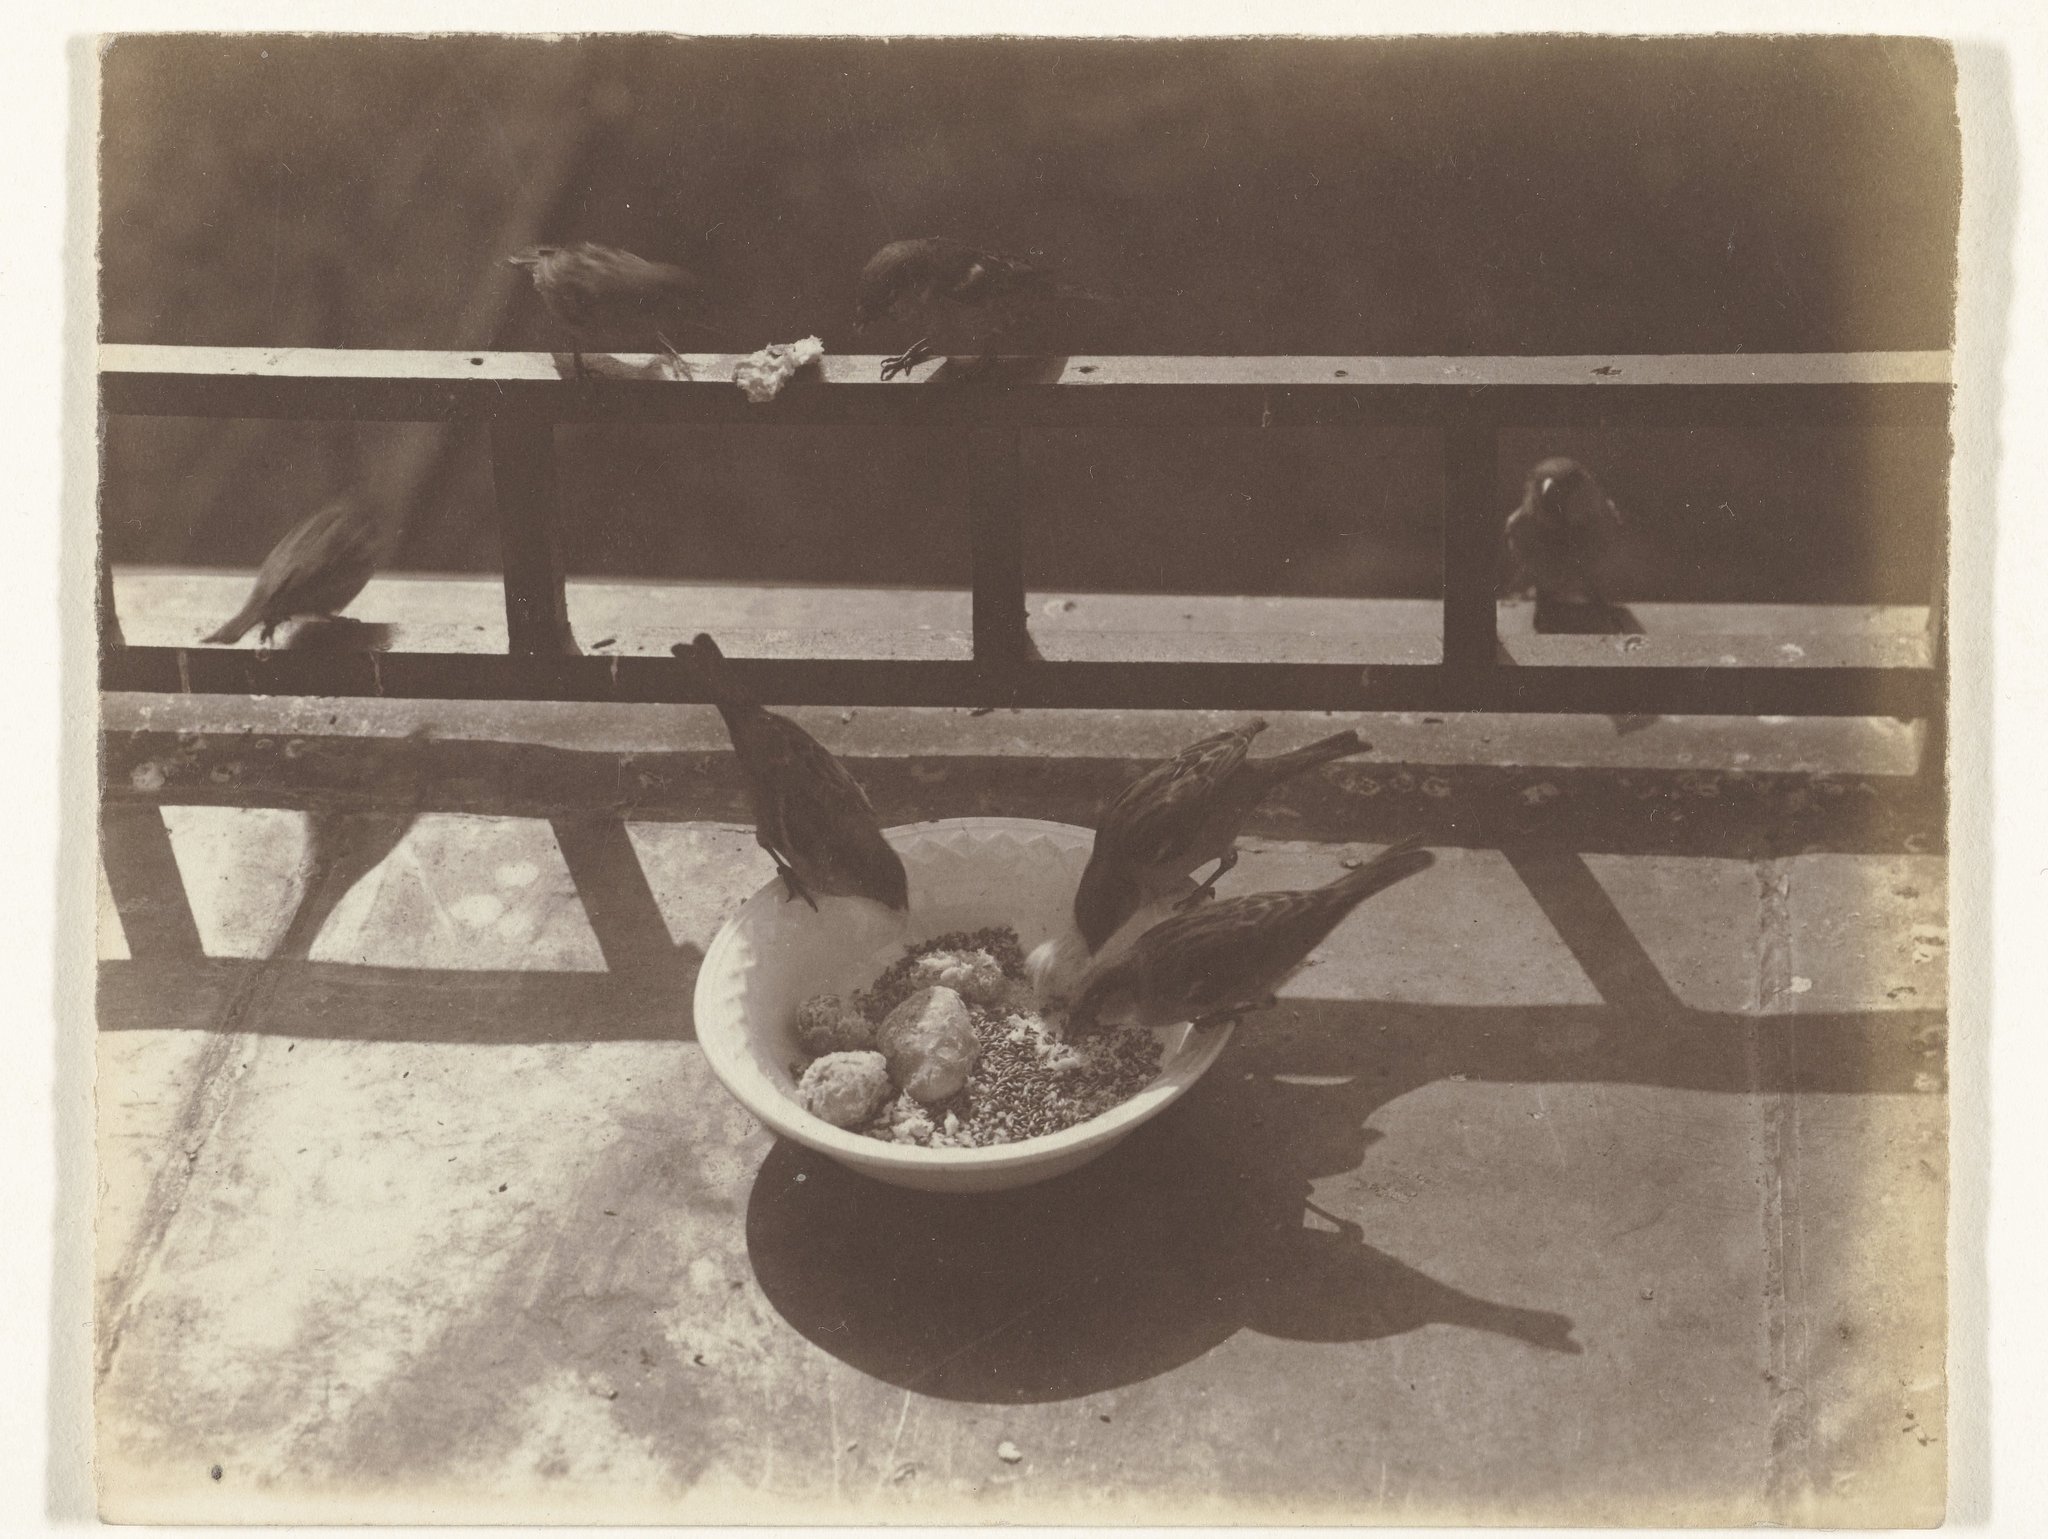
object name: photograph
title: Mussen bij een bakje met voer (vogels)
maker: richard tepe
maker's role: fotograaf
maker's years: 1864-1952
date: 1900-1930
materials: paper, photographic support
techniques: albumen print, salted paper print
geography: netherlands